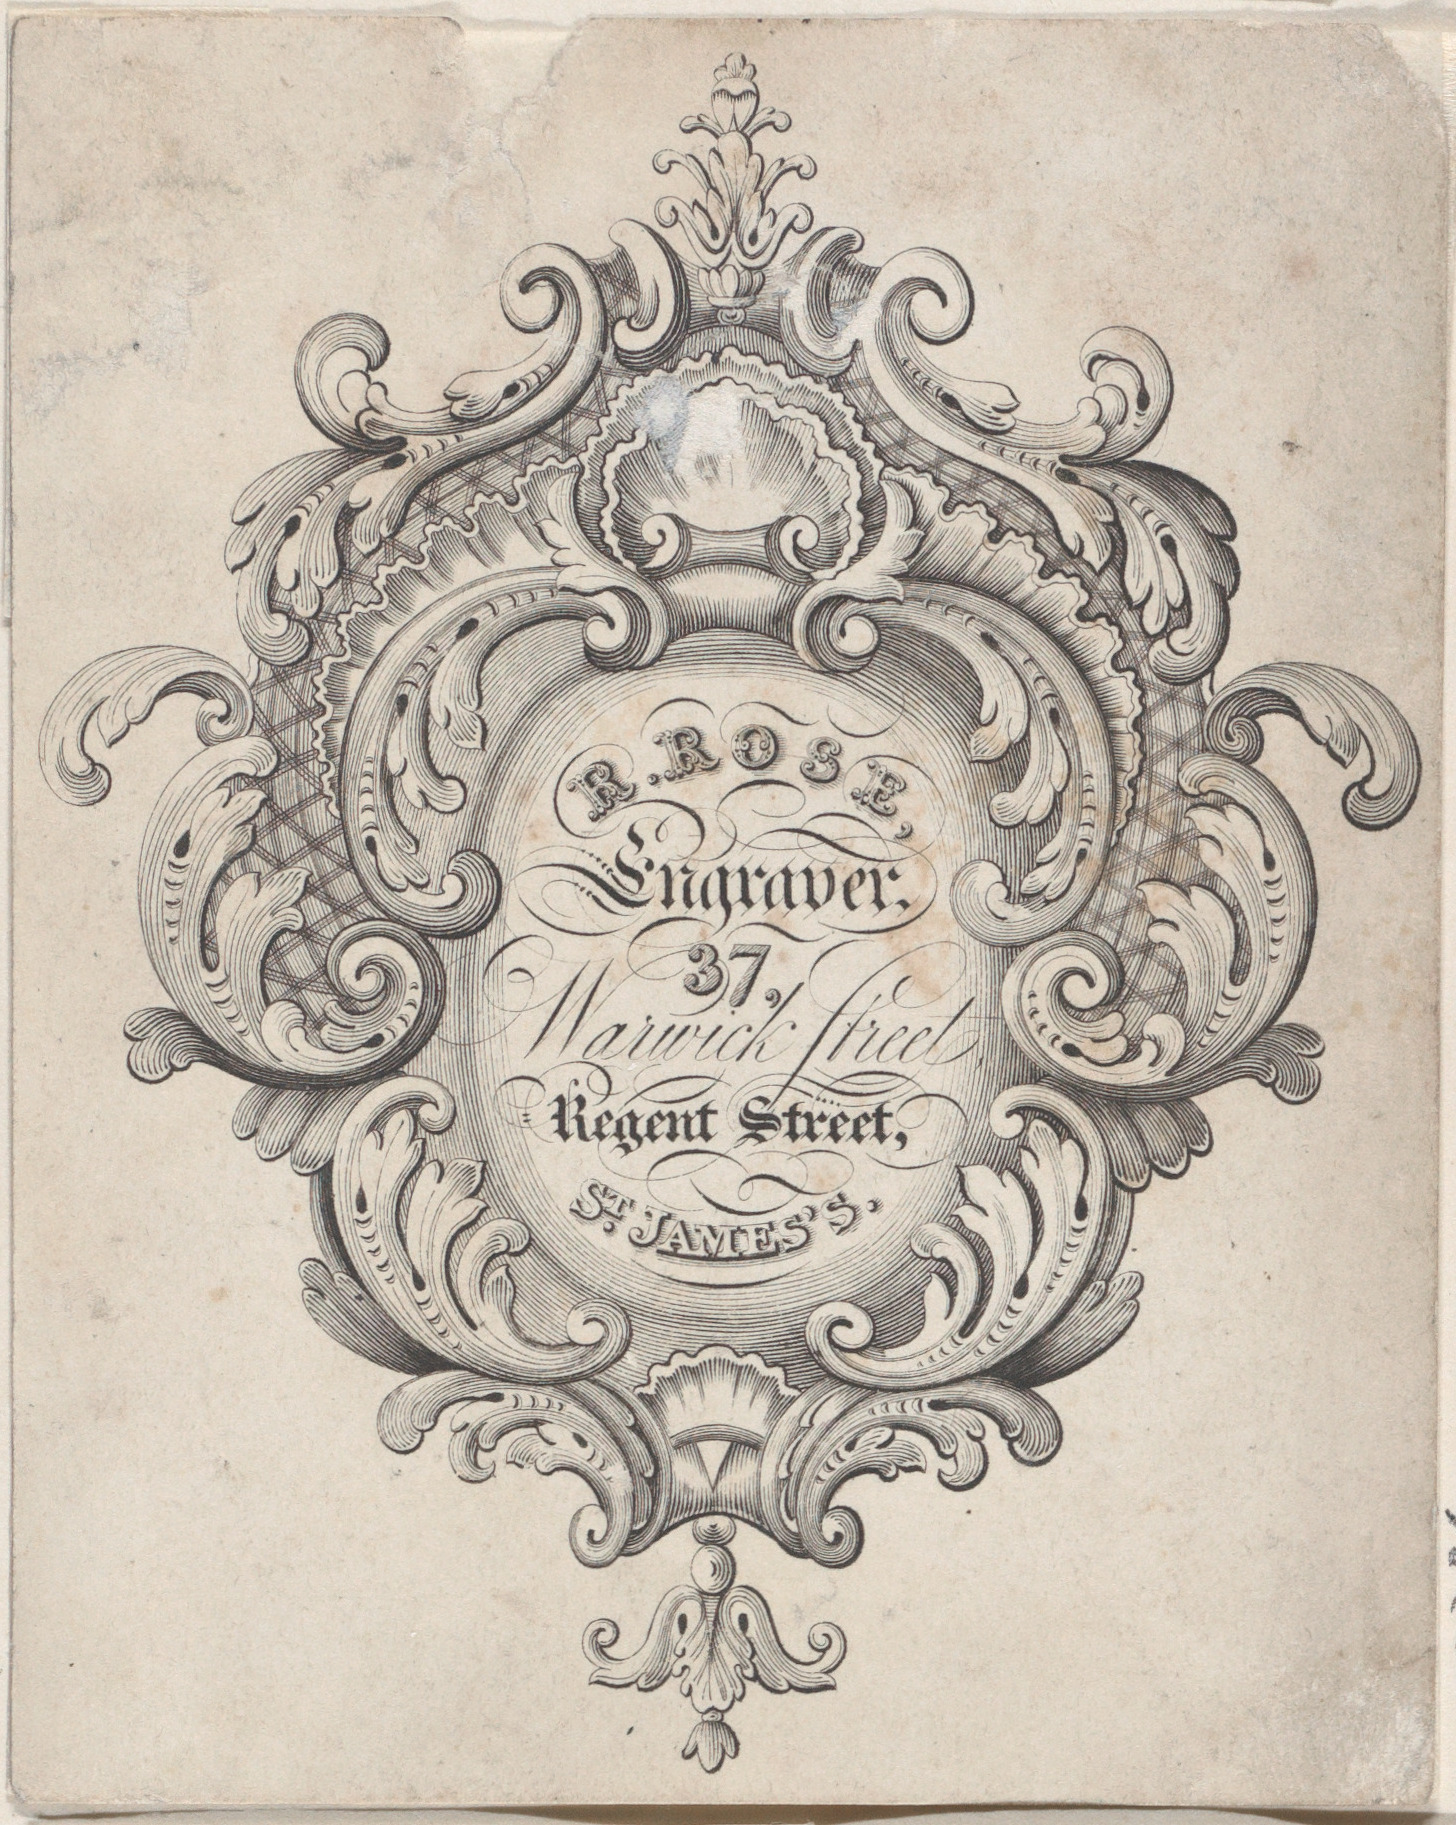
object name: print, trade card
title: Trade Card for R. Rose, Engraver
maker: anonymous, british, 19th century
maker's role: artist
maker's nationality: british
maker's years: 1800-1900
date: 1801-1900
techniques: engraving